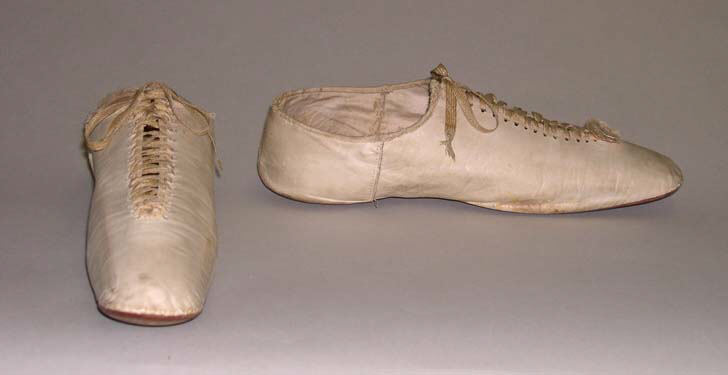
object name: slipper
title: Slippers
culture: american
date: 1850-1855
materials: leather